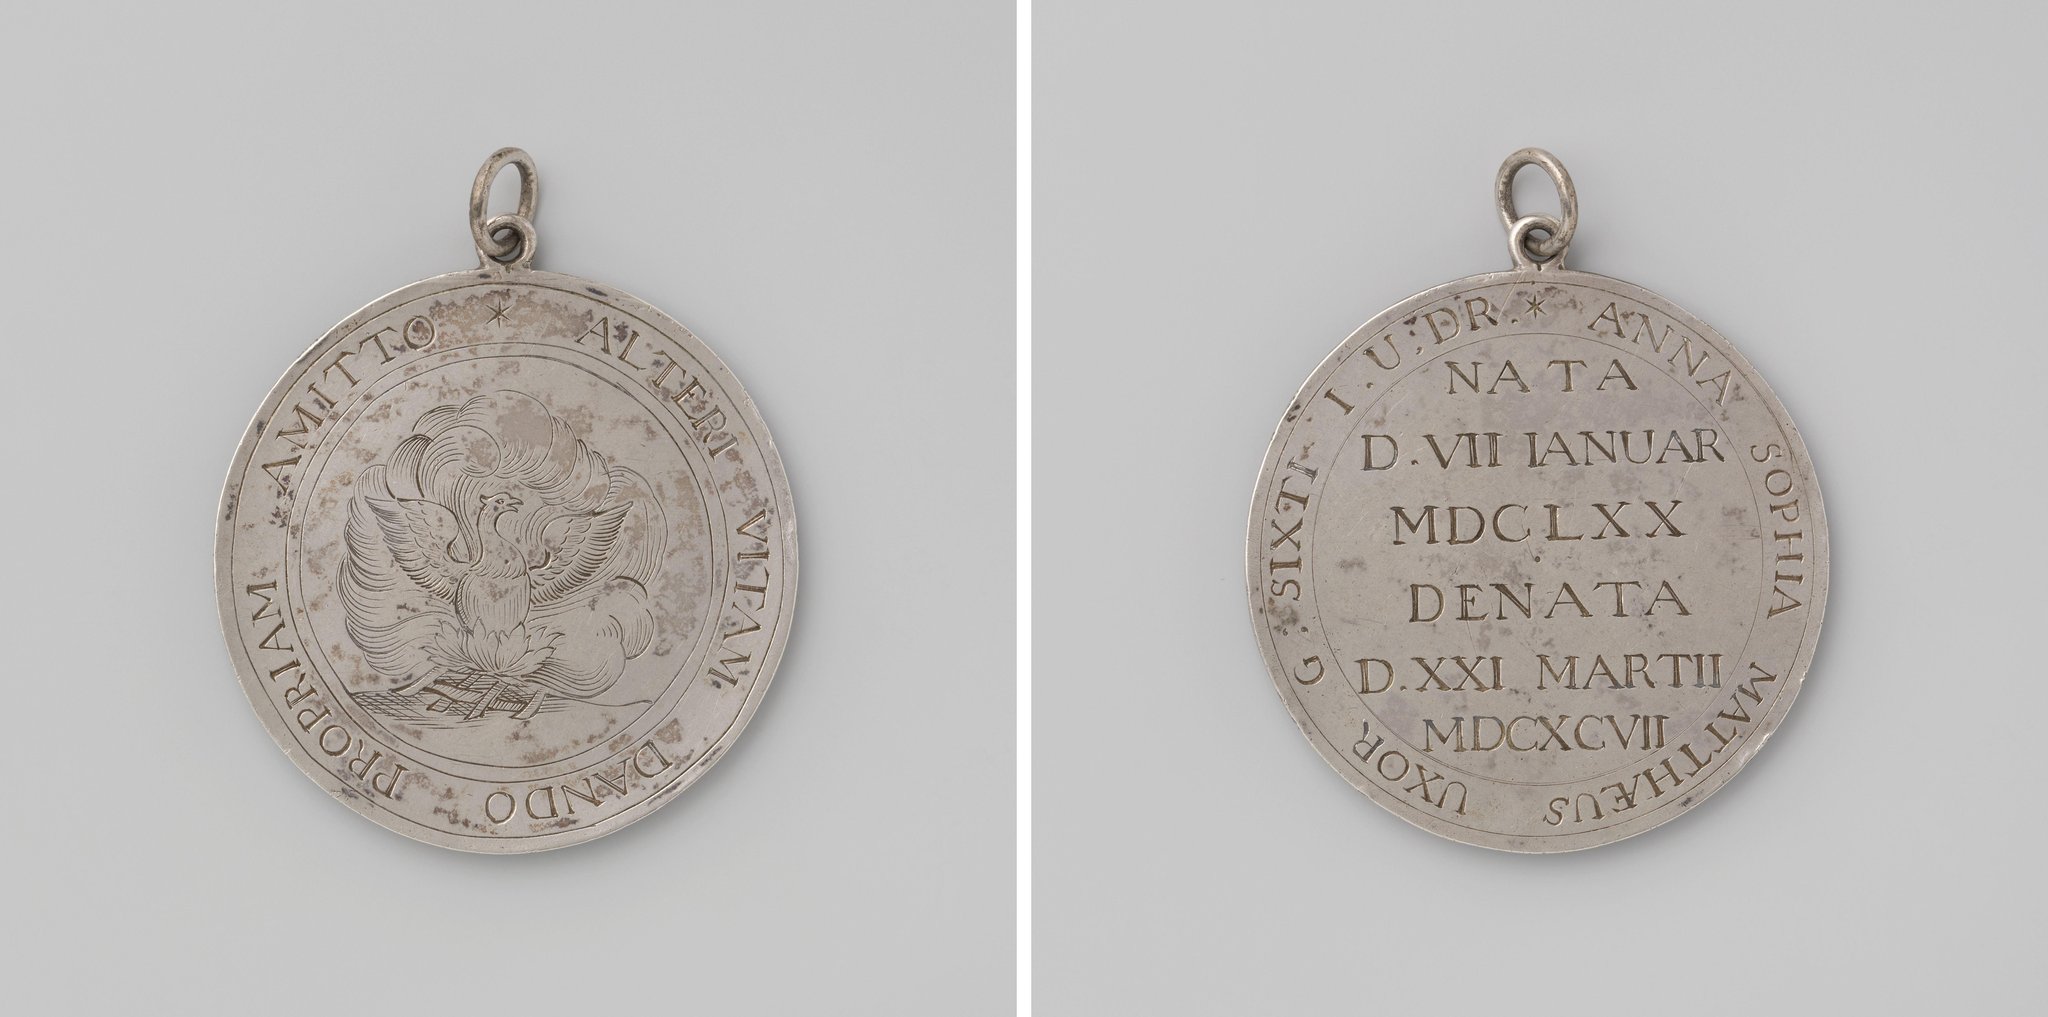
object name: family medal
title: Overlijden van Anna Sophia Matthaeus, vrouw van G. Sixtus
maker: Anonymous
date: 1697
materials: silver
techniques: striking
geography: netherlands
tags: anna sophia matthaeus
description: Zilveren penning met draagoog en draagring. Voorzijde: phoenix herrijzend uit vlammen binnen omschrift. Keerzijde: opschrift binnen omschrift